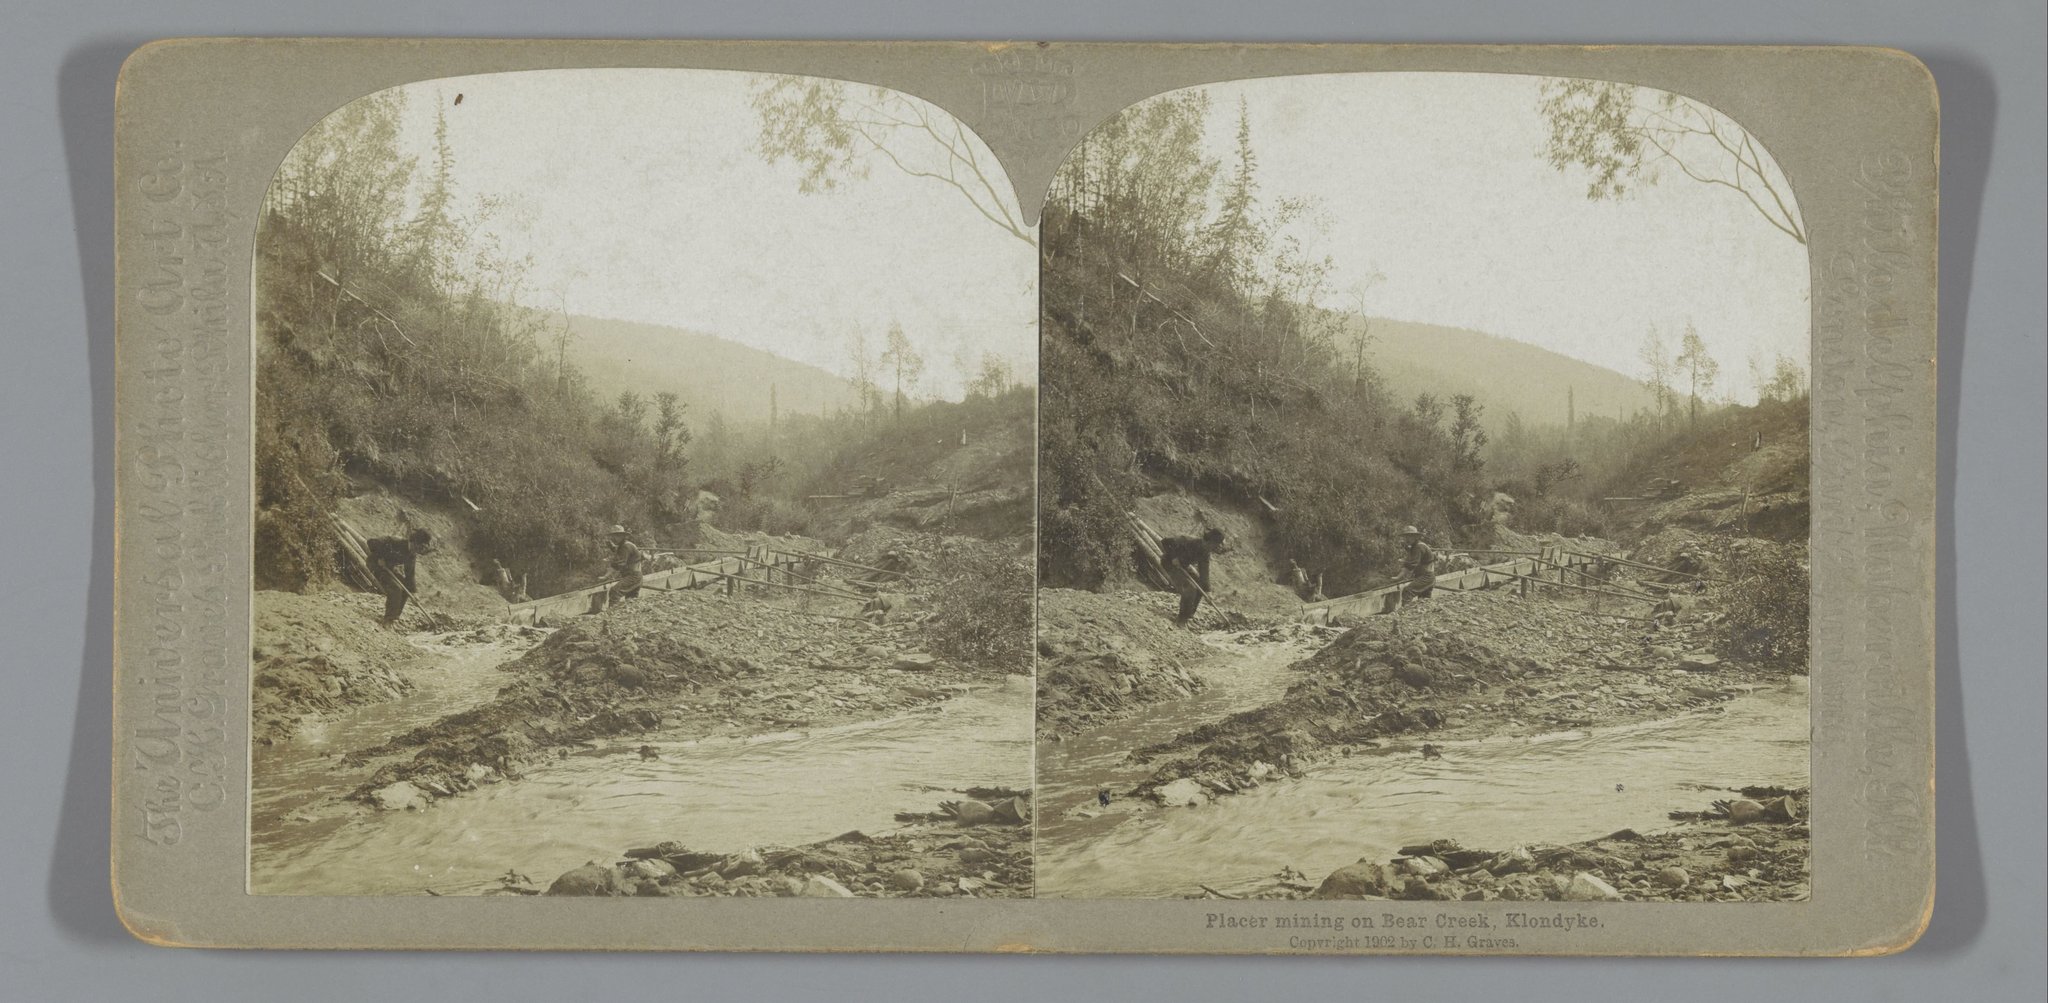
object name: stereograph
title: Goudzoekers in Bear Creek, Klondike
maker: Anonymous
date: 1902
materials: paper, cardboard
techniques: gelatin silver print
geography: philadelphia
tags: mining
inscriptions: copyright notice: ‘Copyright 1902 by C. H. Graves.’, number: ‘30’, number: ‘46’